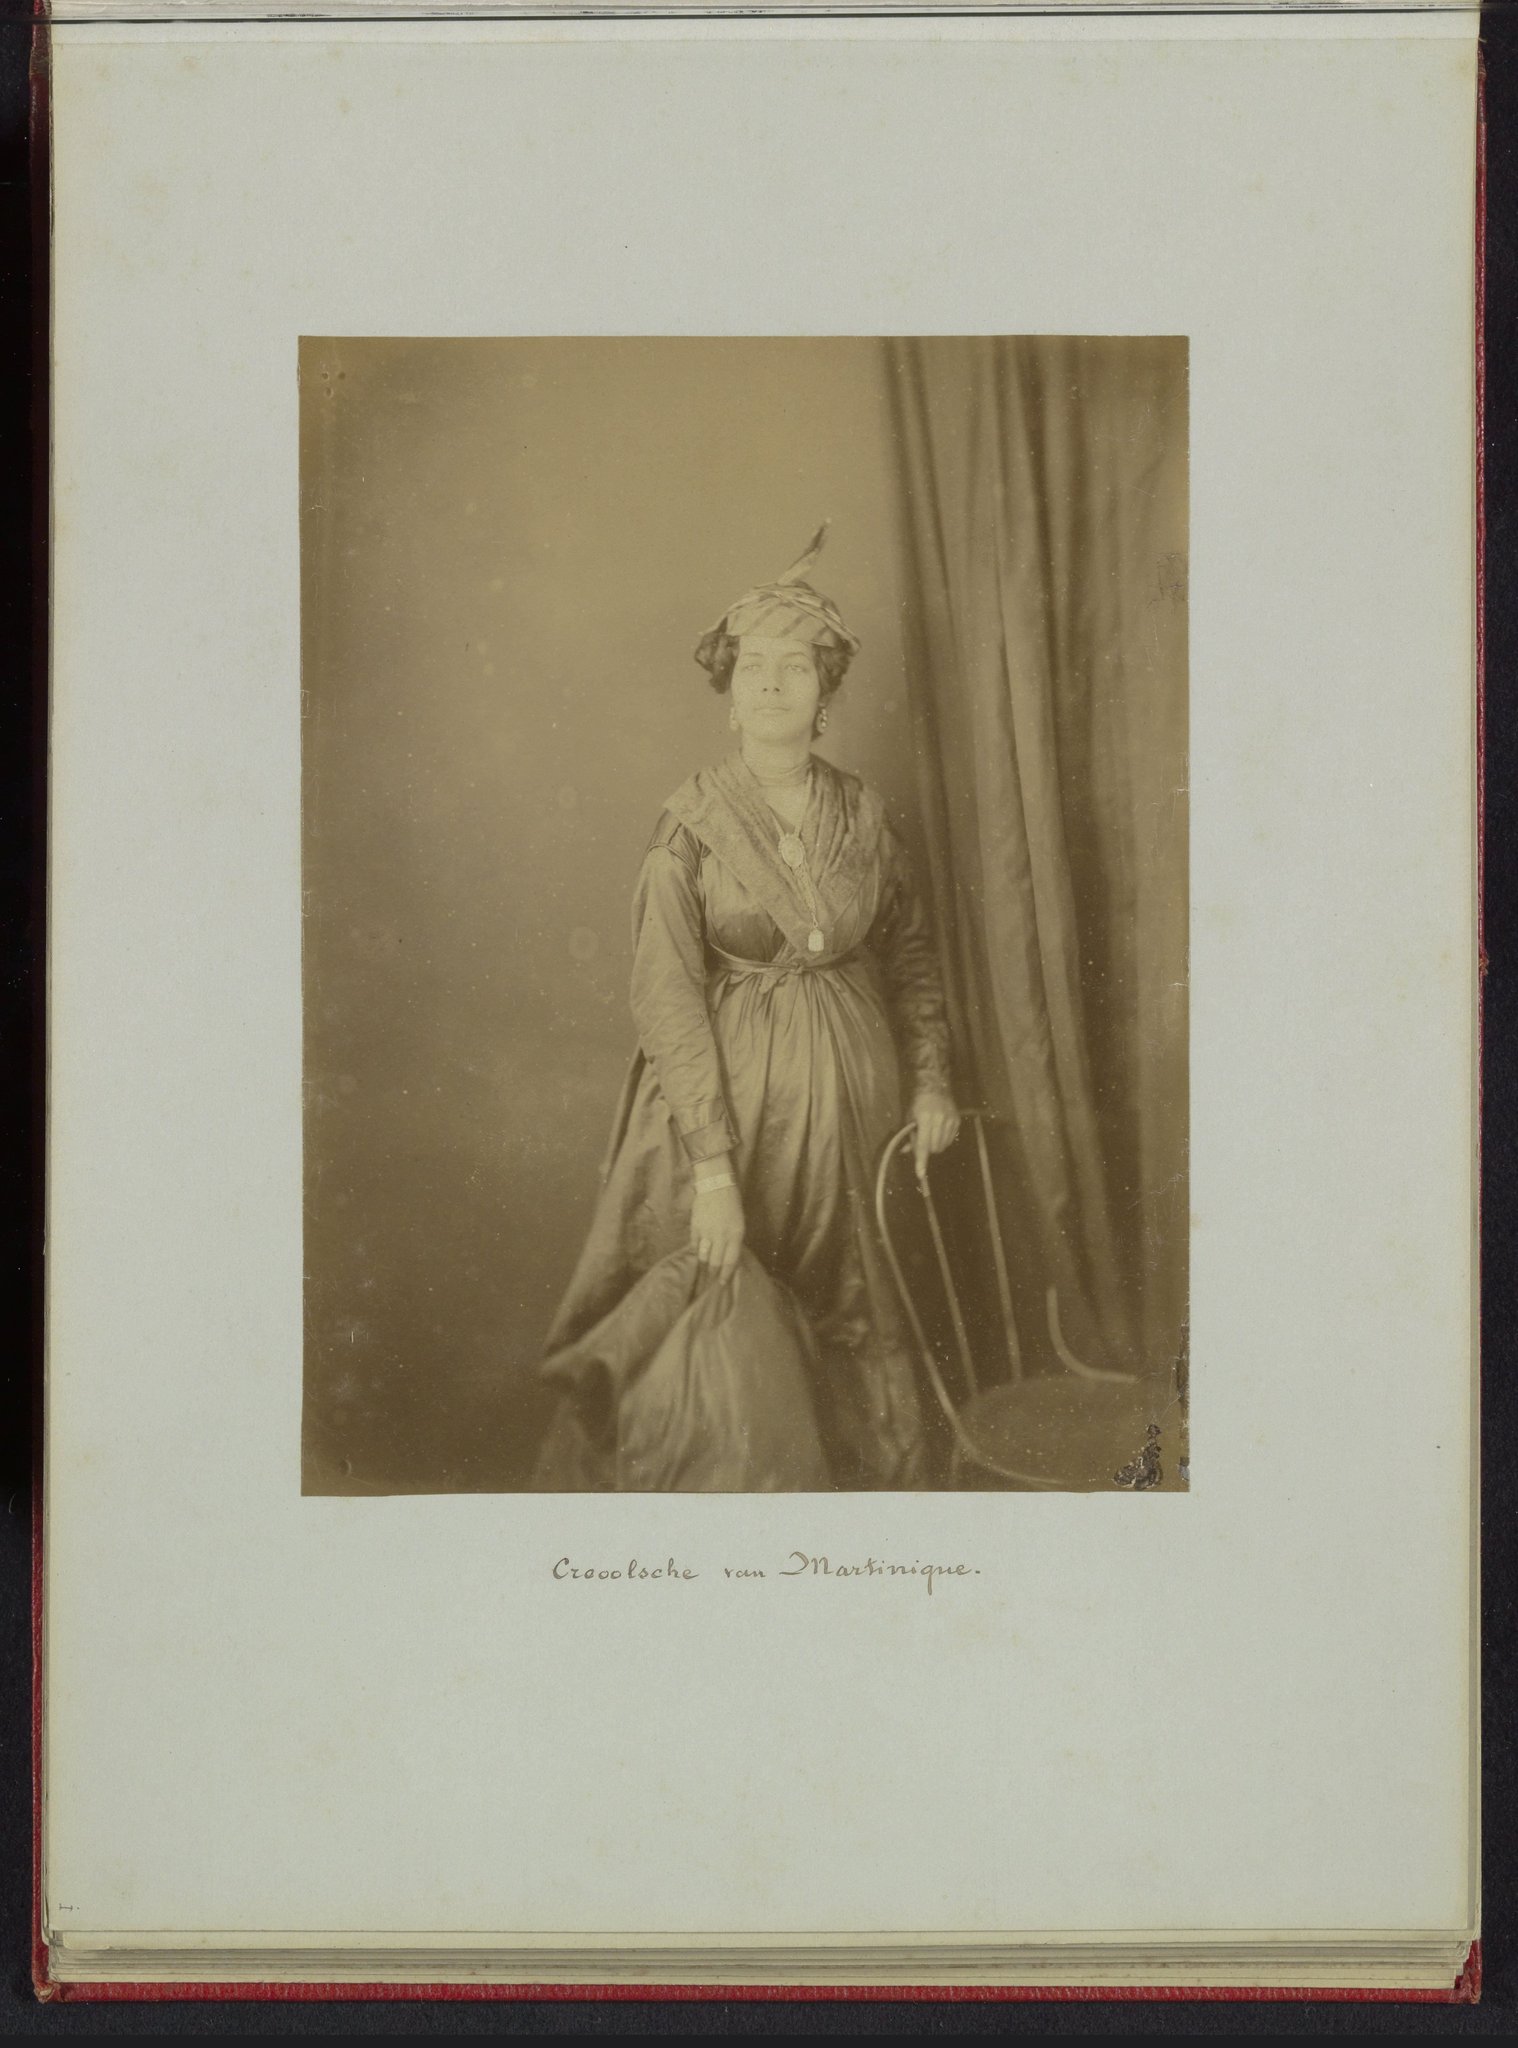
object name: photograph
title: Portret van onbekende Creoolse vrouw op Martinique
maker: Anonymous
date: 1870-1900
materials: photographic support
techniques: albumen print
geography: martinique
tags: studio requisites ~ photographer, adult man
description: Onderdeel van Fotoalbum met opnames van bezienswaardigheden in Europa, Trinidad, Haïti, Martinique en Suriname.